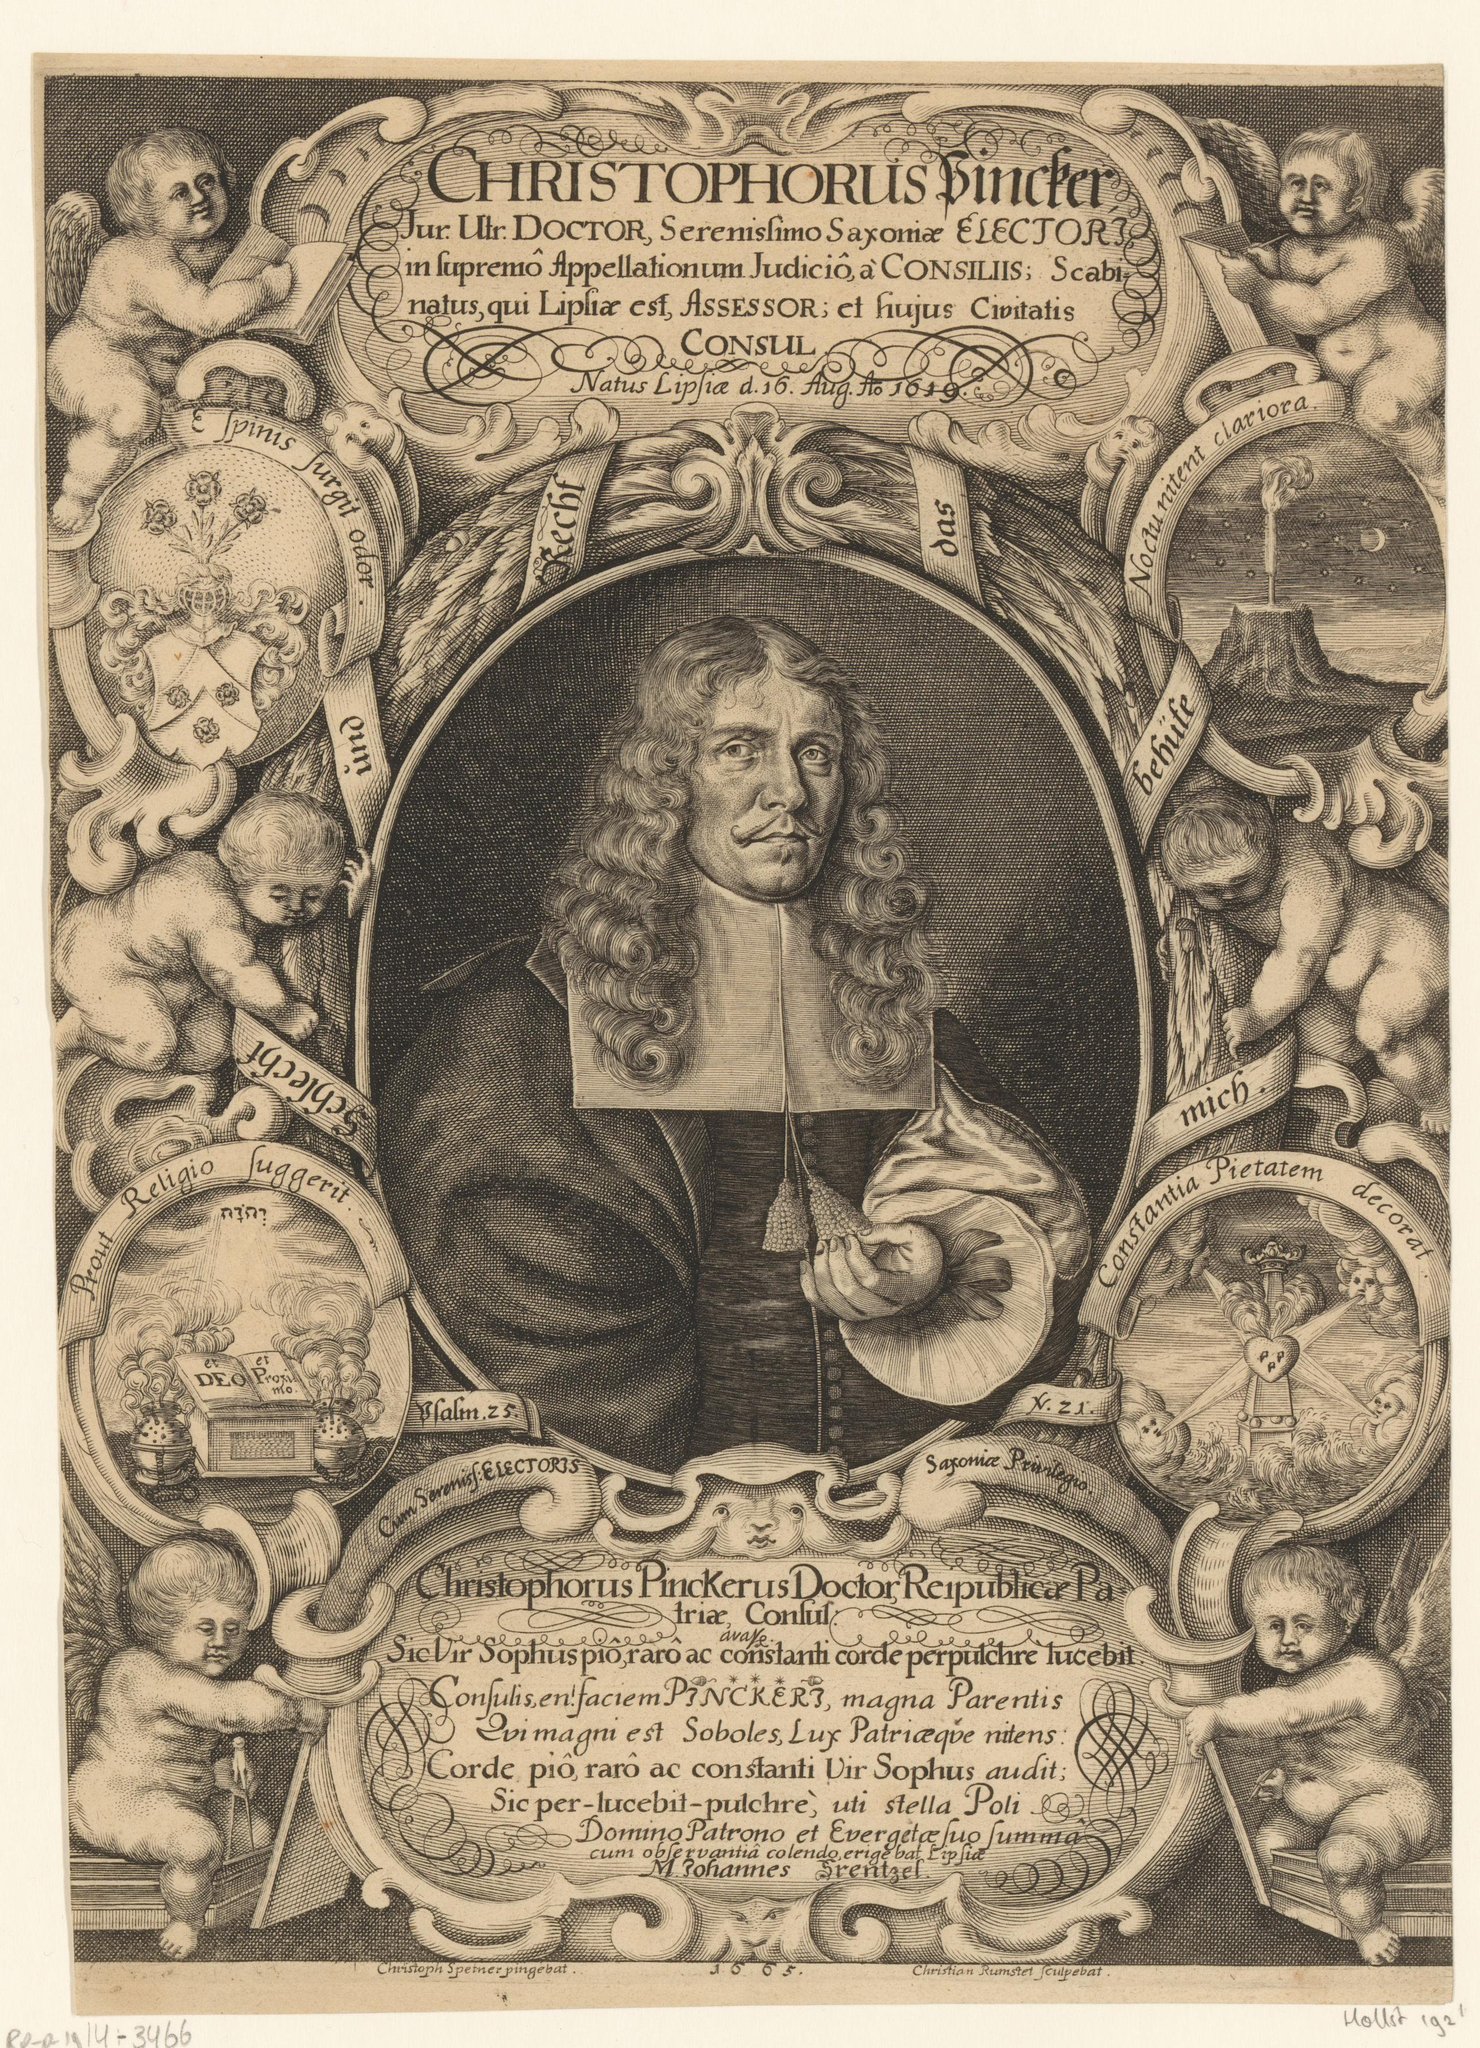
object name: print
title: Portret van Christoph Pincker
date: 1665-1721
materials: paper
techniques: engraving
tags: historical persons, abstract ideas and concepts (+ emblematical representation of concept), cupids: 'amores', 'amoretti', 'putti'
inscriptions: collector's mark: Lugt 2228